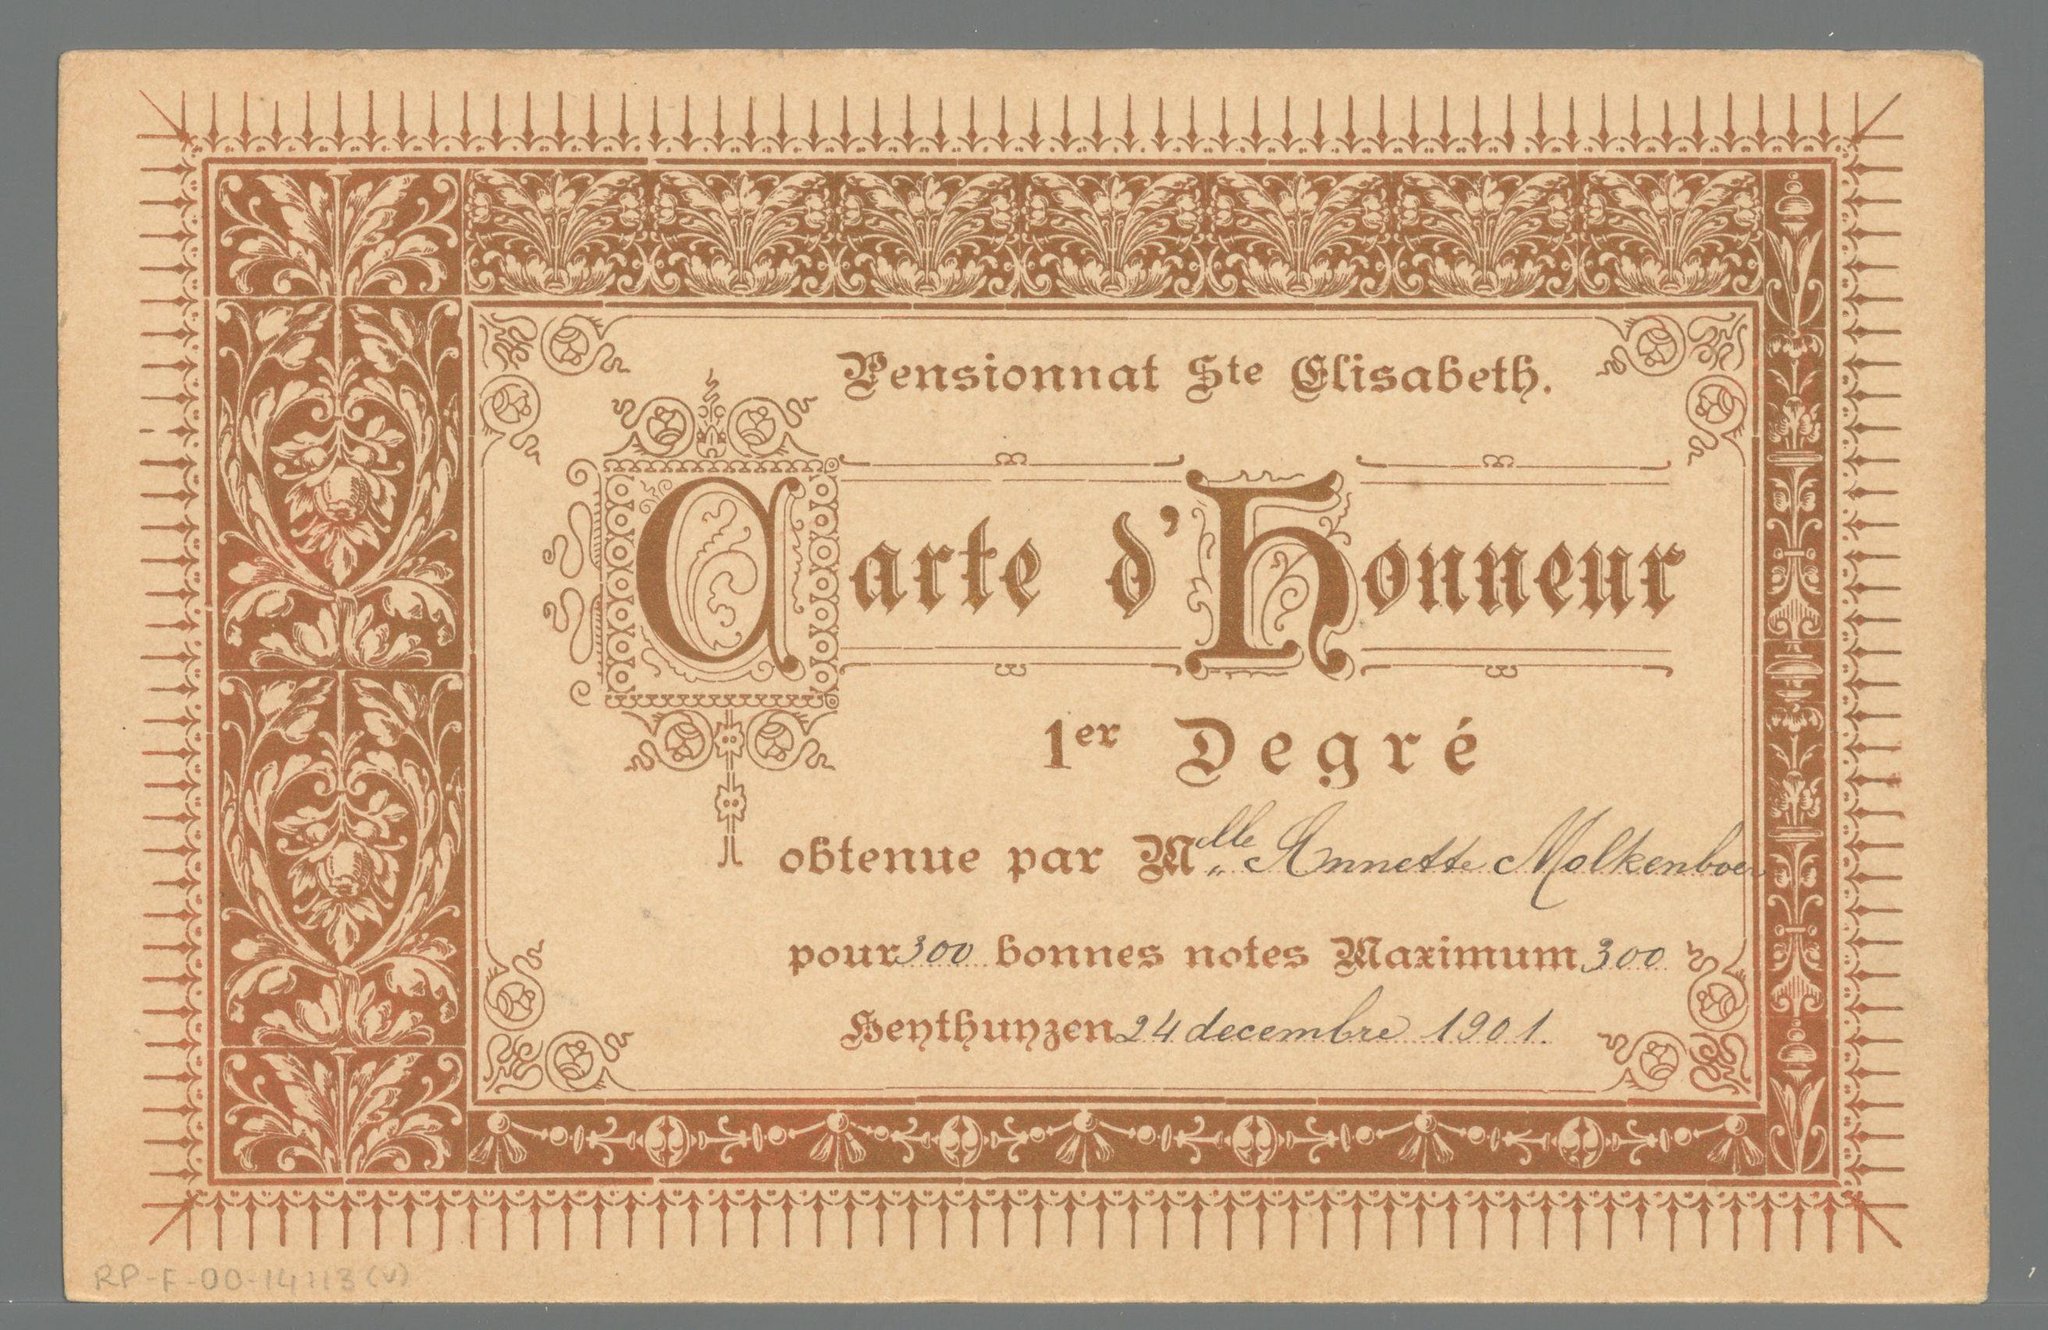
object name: print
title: Beloningskaart (carte d'honneur) van het pensionaat Sint-Elisabeth te Heythuysen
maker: Anonymous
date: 1897-1901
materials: cardboard, ink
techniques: lithograph, pen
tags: abbey, monastery, convent ~ roman catholic church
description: Beloningskaart voor het behalen van goede cijfers, uitgereikt aan Annette Molkenboer.